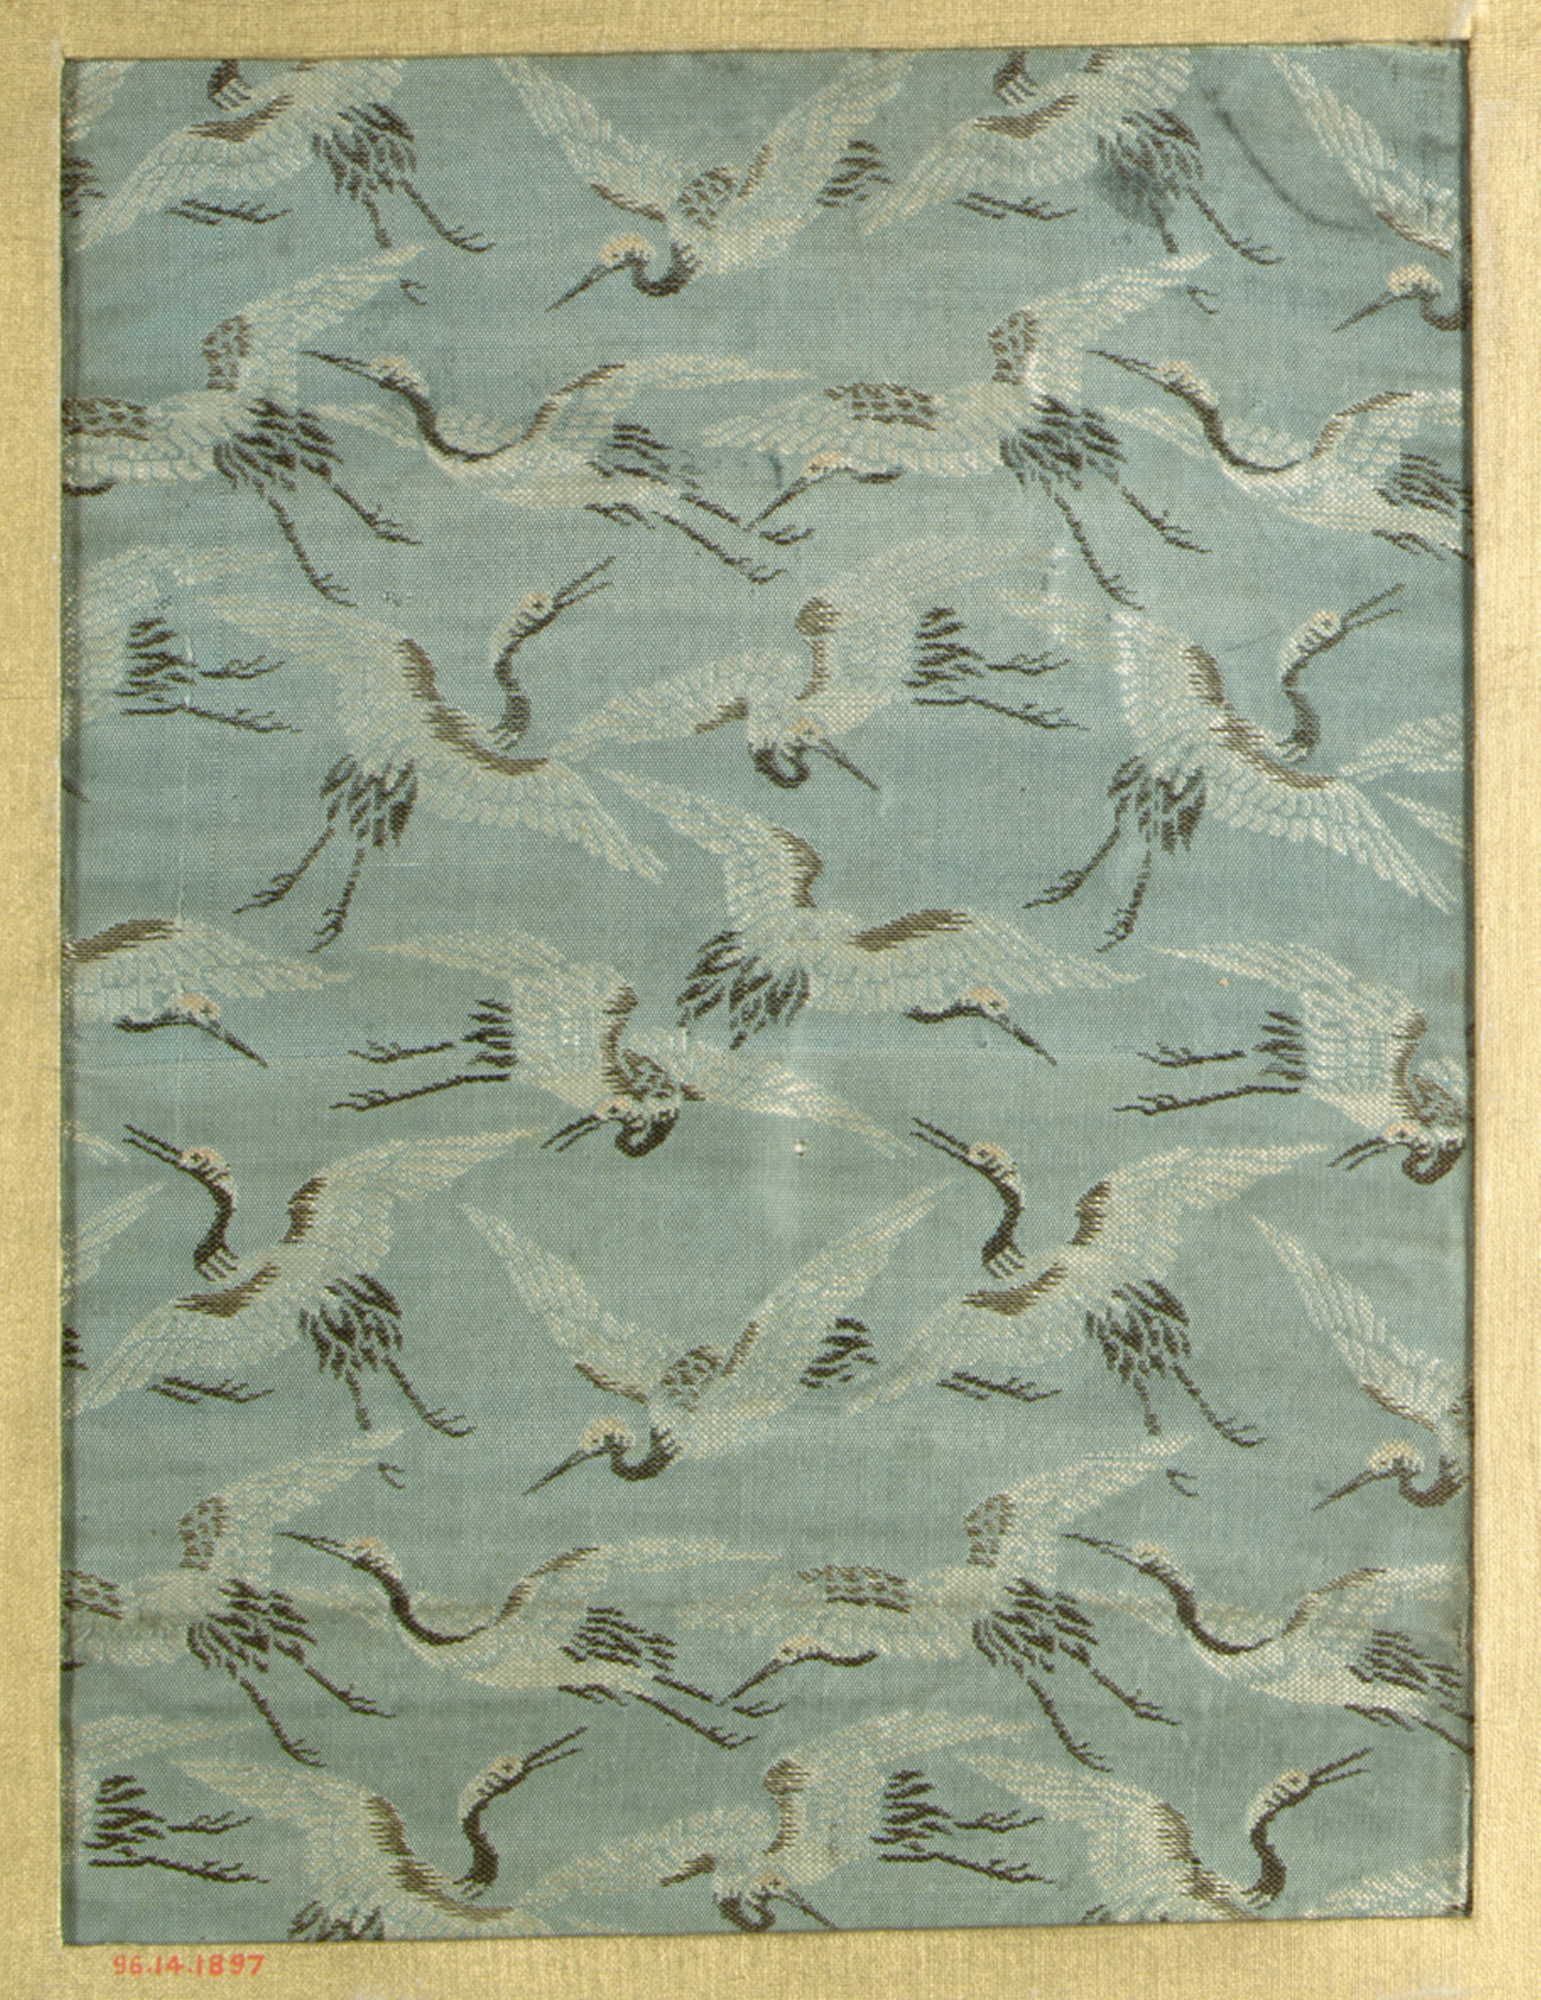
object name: piece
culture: japanese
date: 1701-1900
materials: silk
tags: cranes